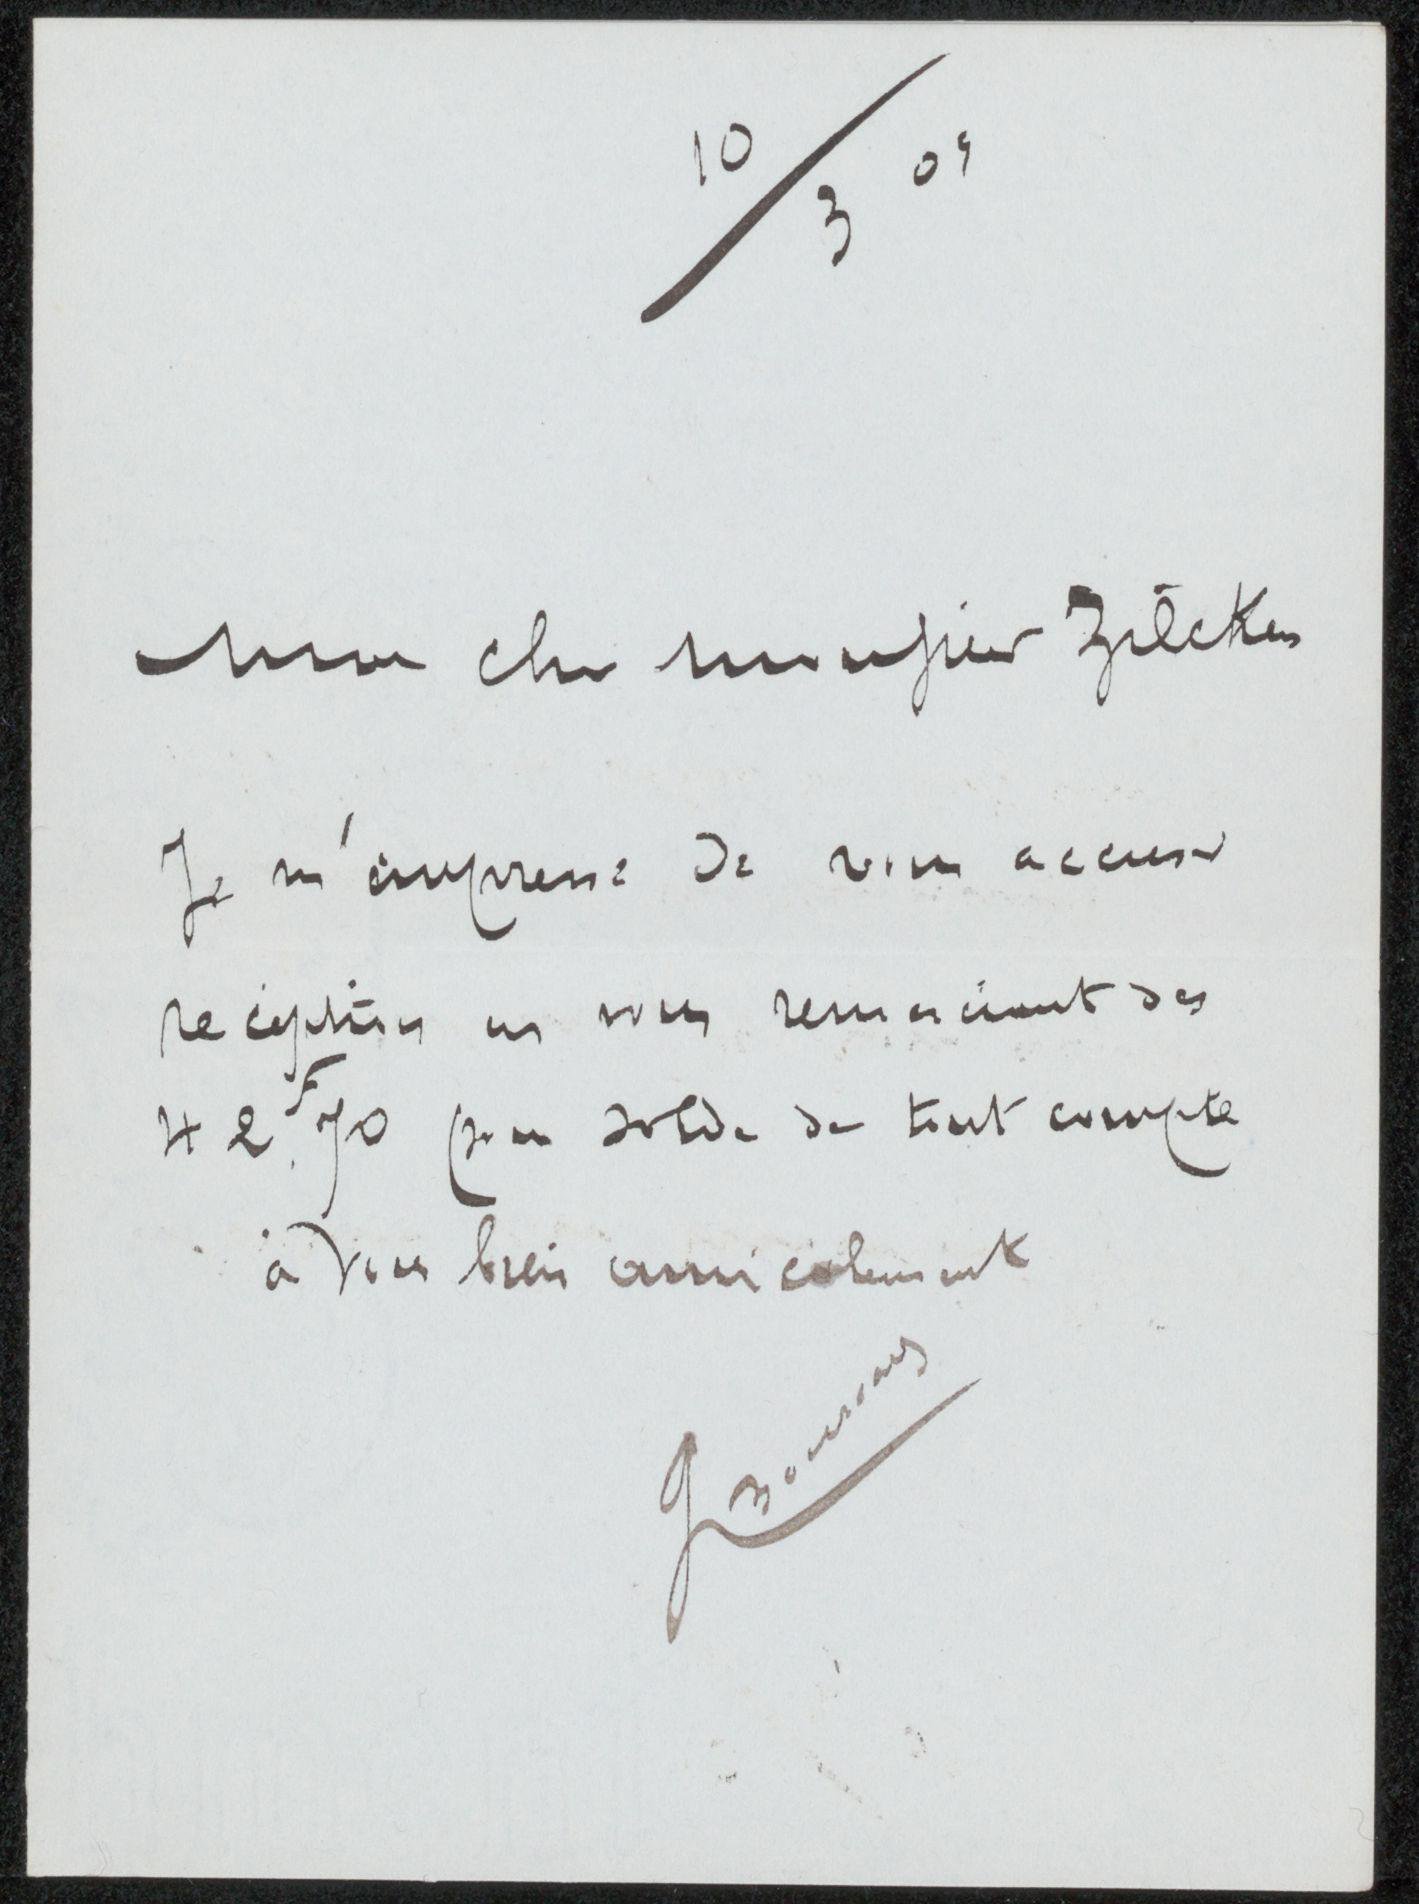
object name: letter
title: Brief aan Philip Zilcken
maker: gustave bourcard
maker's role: verzamelaar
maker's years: 1846-1925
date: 1909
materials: ink, paper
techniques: pen, writing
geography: nantes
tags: painter, draughtsman, philip zilcken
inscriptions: collector's mark: ‘RPK’, seal